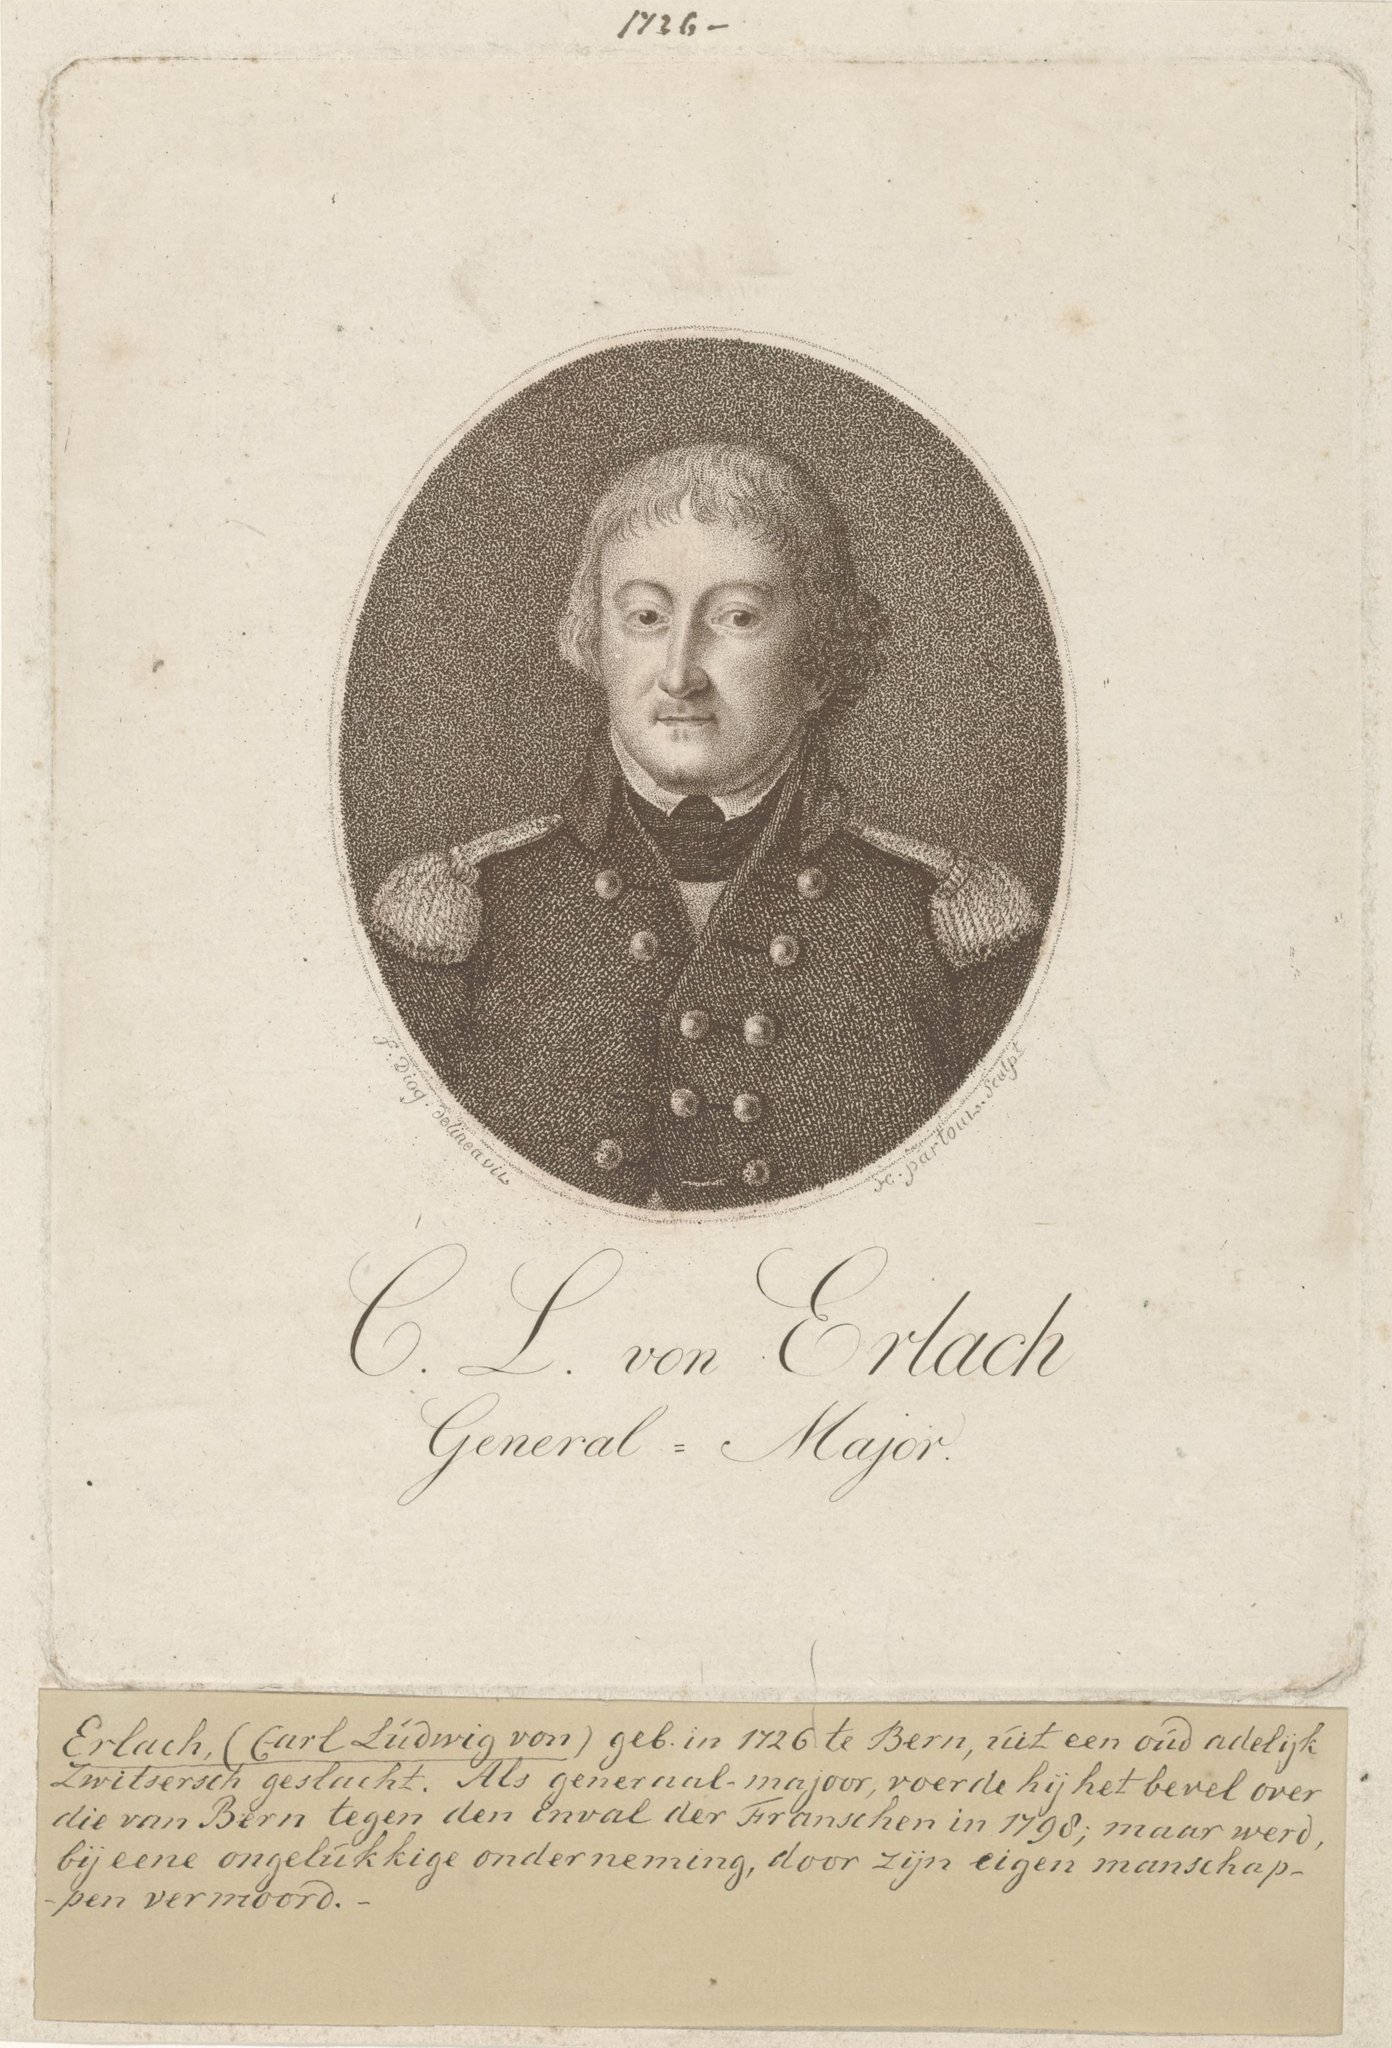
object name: print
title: Portret van Karl Ludwig von Erlach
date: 1769-1789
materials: paper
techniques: etching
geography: zeeland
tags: bern, generaal, karl ludwig von erlach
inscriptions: inscription: ‘Erlach, (Carl Ludwig von) geb. in [...] door zijn eigen manschap-penn vermoord.-’, inscription: ‘1726 -’, collector's mark: Lugt 2228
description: Busteportret van Karl Ludwig von Erlach, in militair kostuum. Het portret is gevat in een ovale omlijsting. In de marge de naam en functie van de geportretteerde.